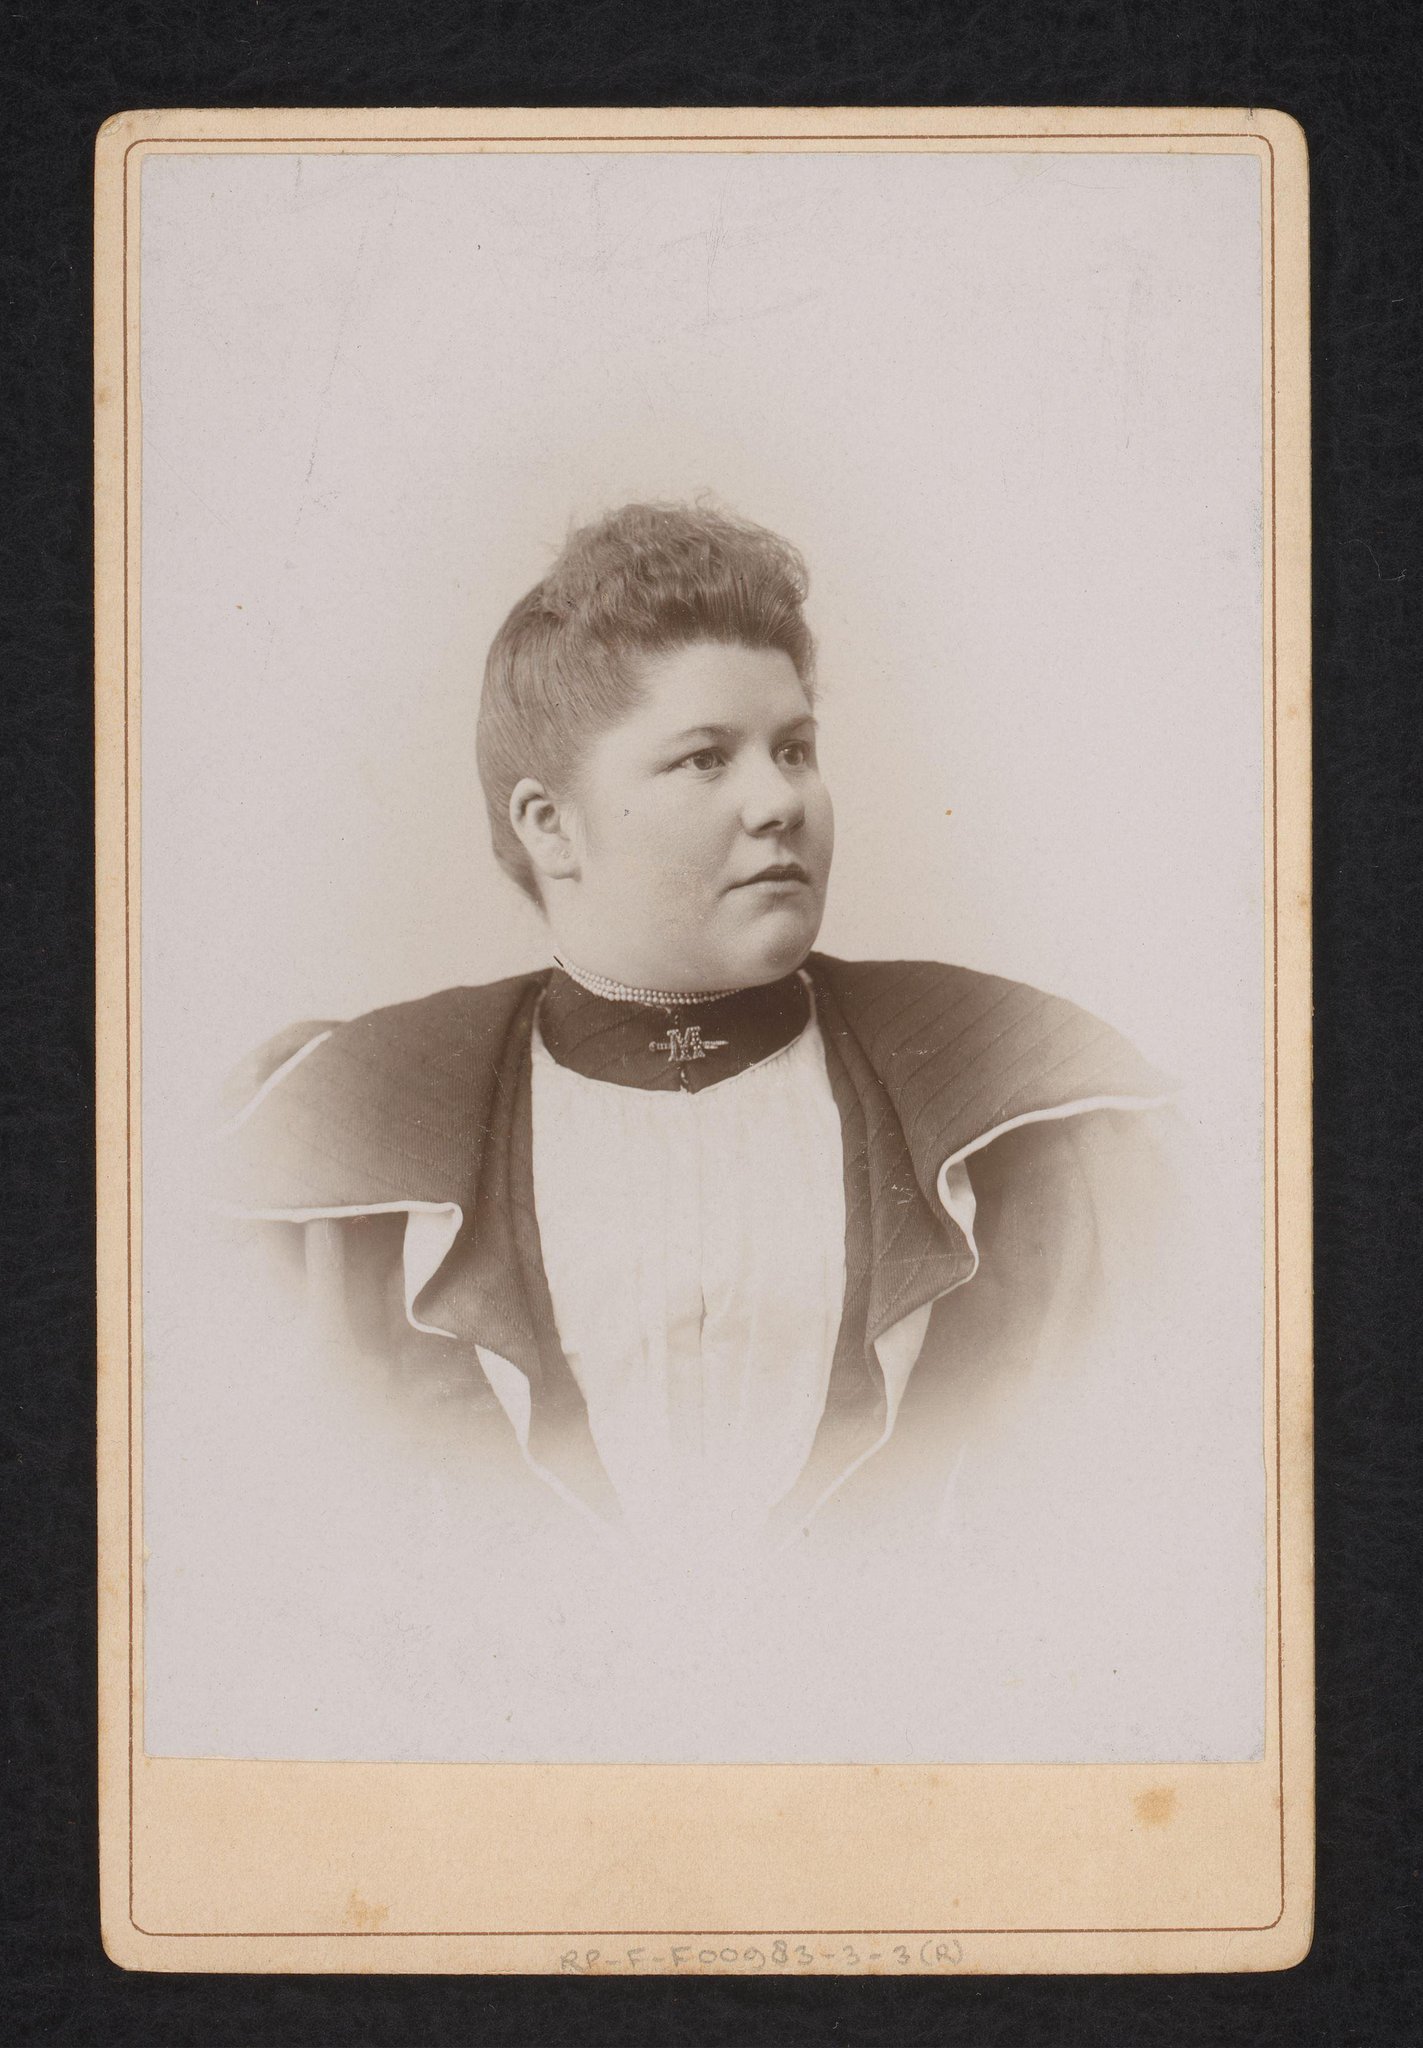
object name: album leaf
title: Portret van een vrouw met speld met de letter M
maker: Anonymous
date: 1880-1920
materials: cardboard, photographic support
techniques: collodion silver print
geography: netherlands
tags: historical persons - bb - woman, pin